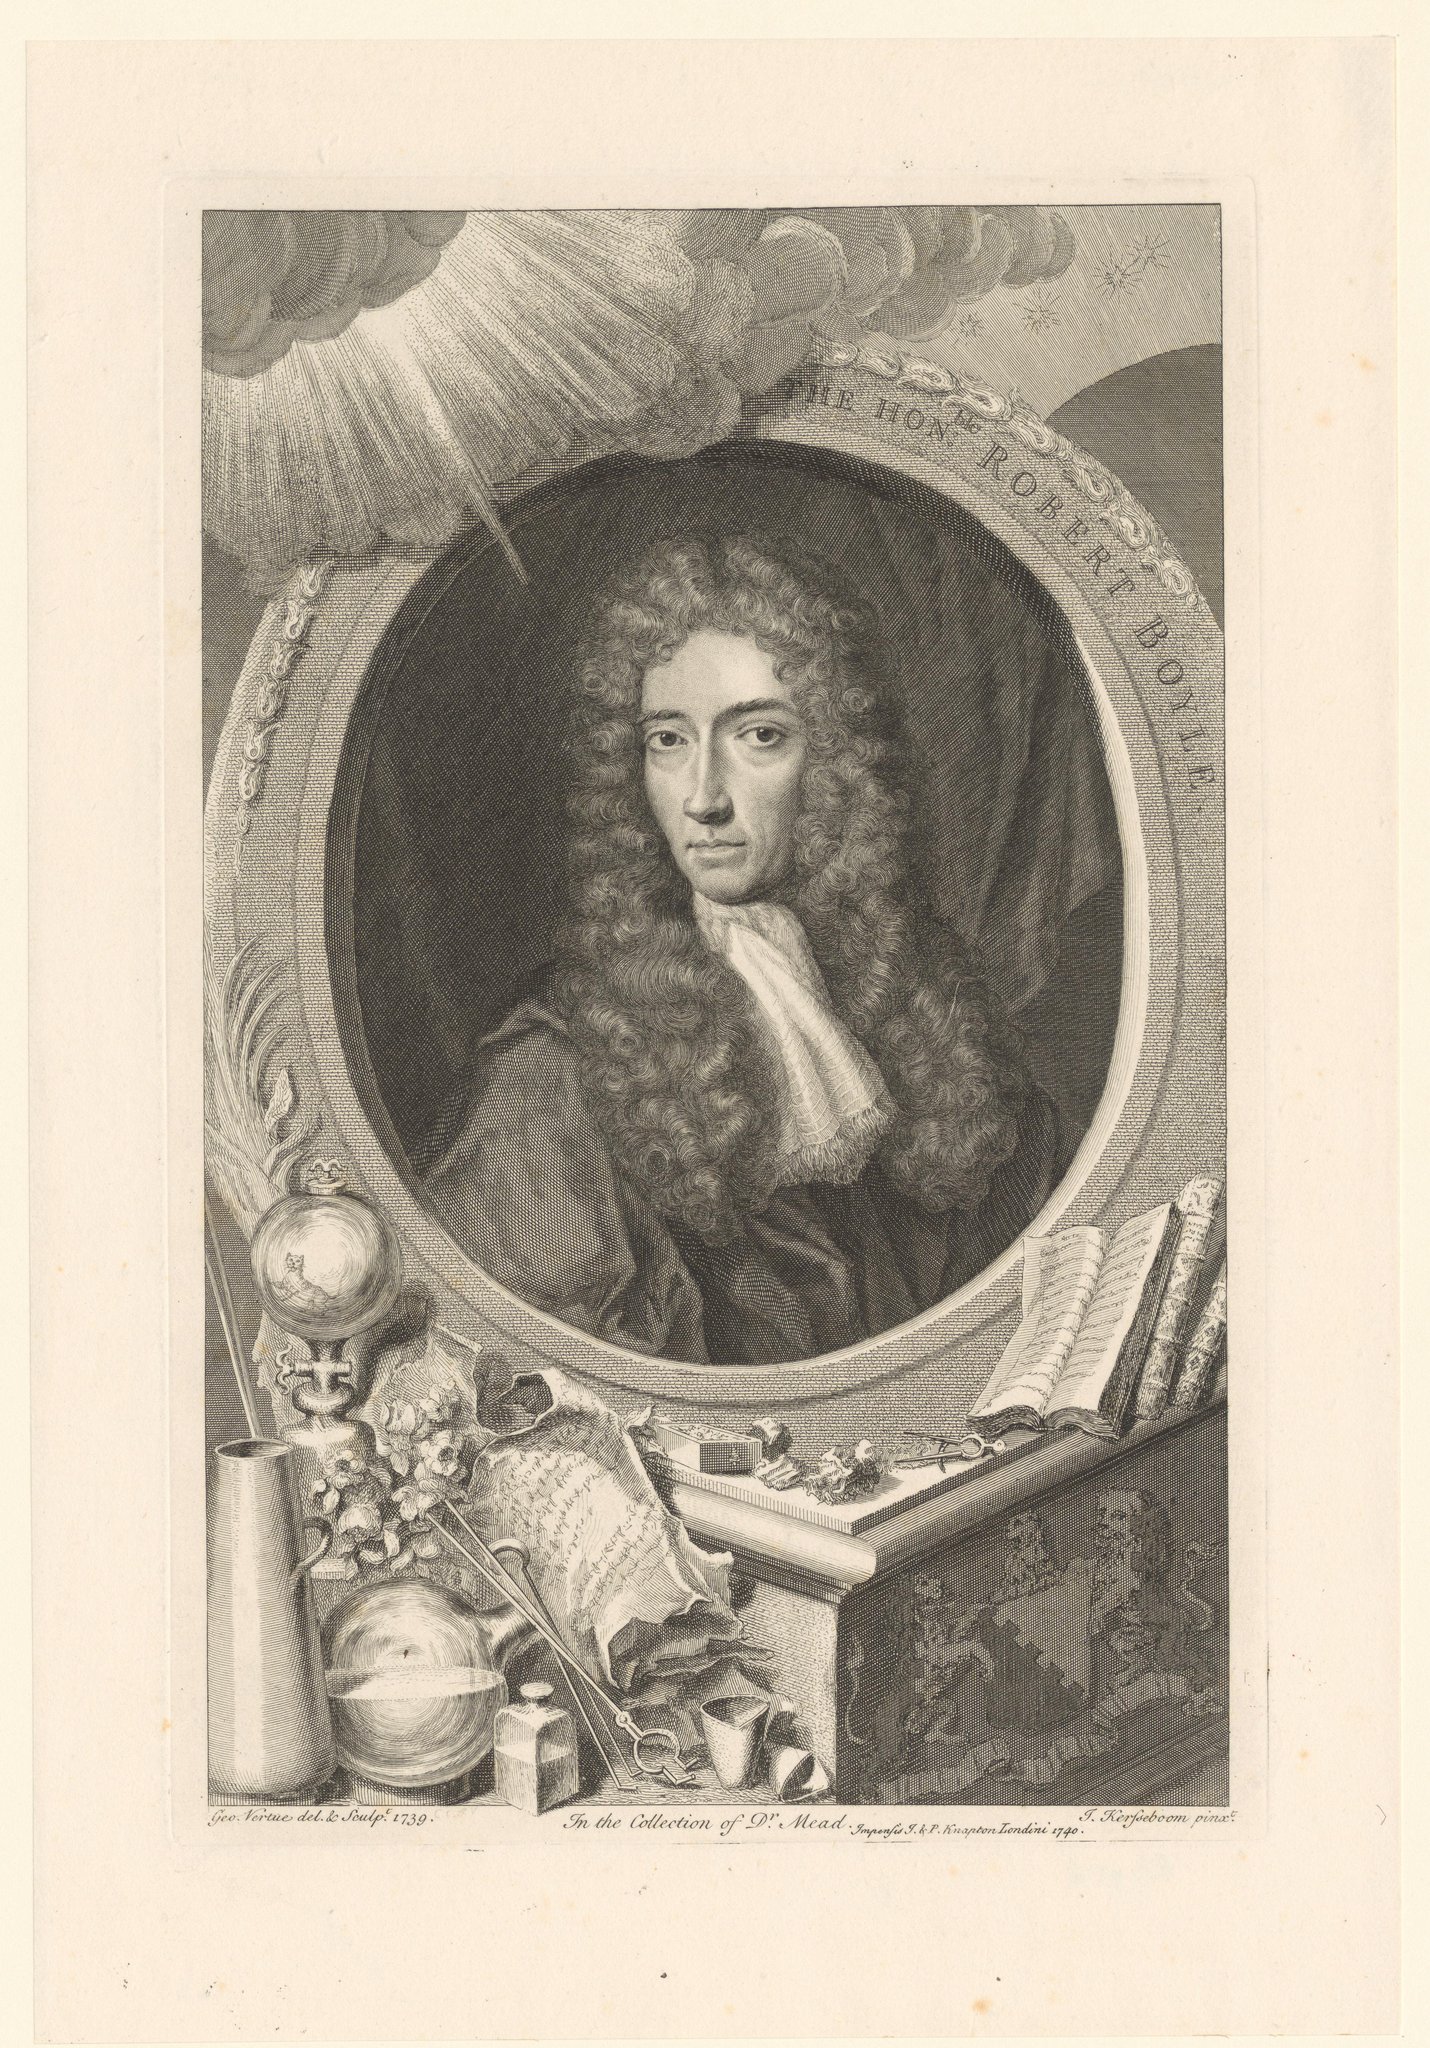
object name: print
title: Portret van Robert Boyle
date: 1740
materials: paper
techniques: engraving, etching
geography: london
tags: london, chemistry (+ portrait of scholar, scientist), physics and mechanics (+ portrait of scholar, scientist), historical persons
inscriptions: collector's mark: Lugt 2228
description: Prent gebruikt in: Tindal, Nicolas. The continuation of Mr Rapin de Thoyras's history of England (...). Londen: John & Paul Knapton e.a., [1740-1763]; en: Birch, Thomas. The heads of illustrious persons of Great Britain (...). Londen: John & Paul Knapton, 1747, p. 134.